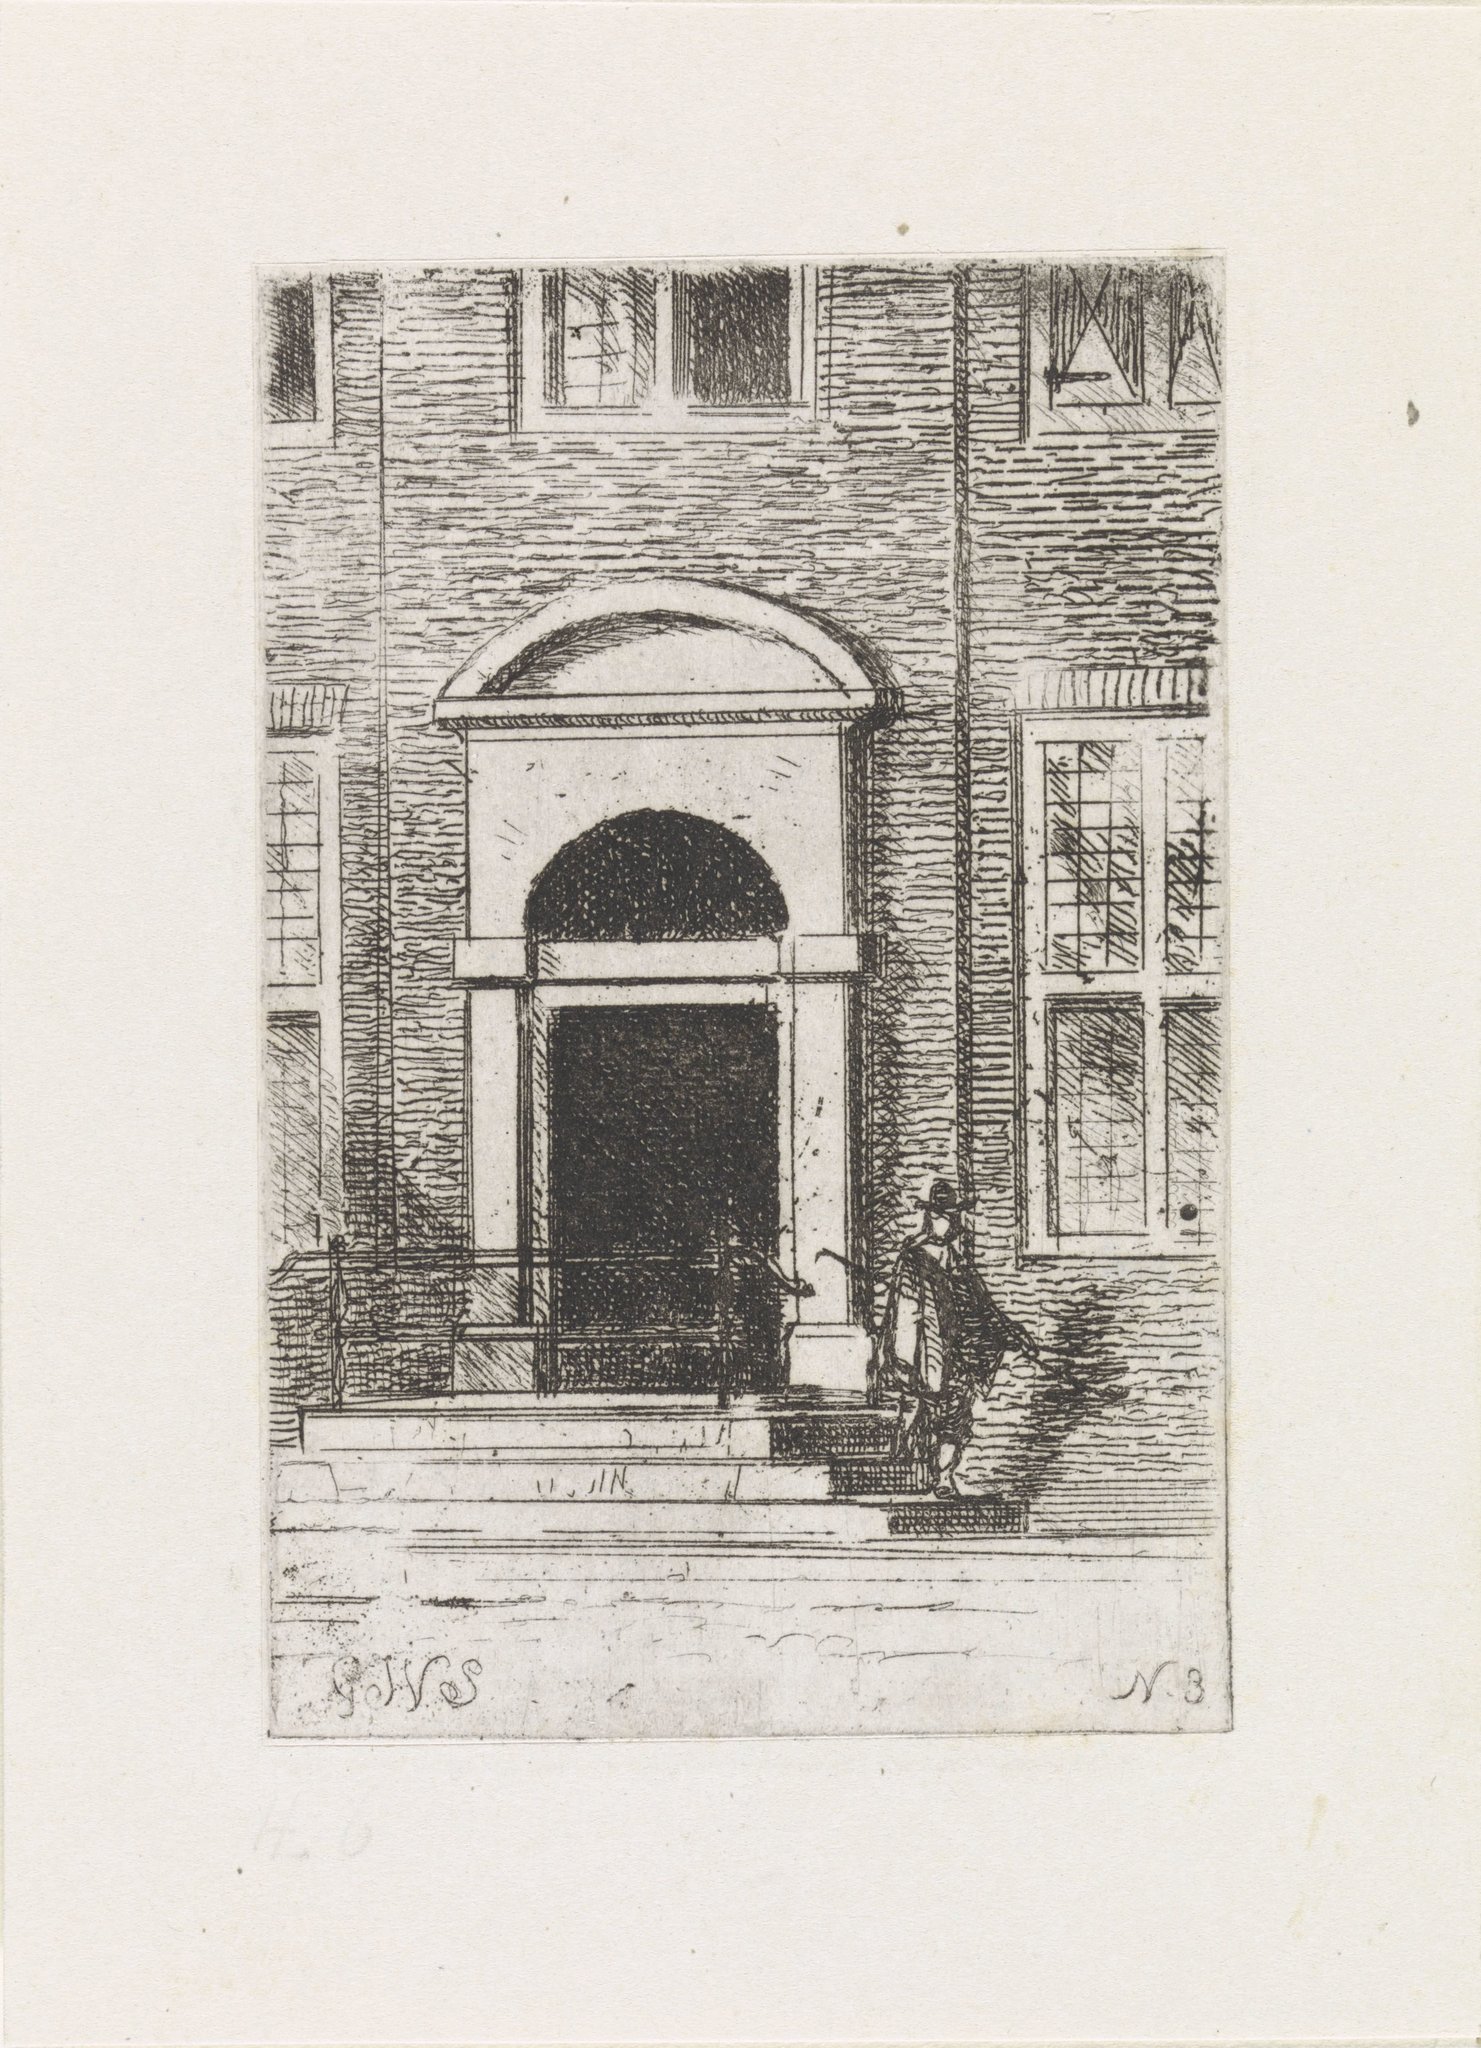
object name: print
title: Man op een trap bij een deur van een huis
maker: gijsbertus johannes verspuy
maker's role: print maker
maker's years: 1823-1862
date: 1833-1862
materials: paper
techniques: etching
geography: netherlands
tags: monumental door, porch, 'aediculum', front steps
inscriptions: collector's mark: Lugt 2228